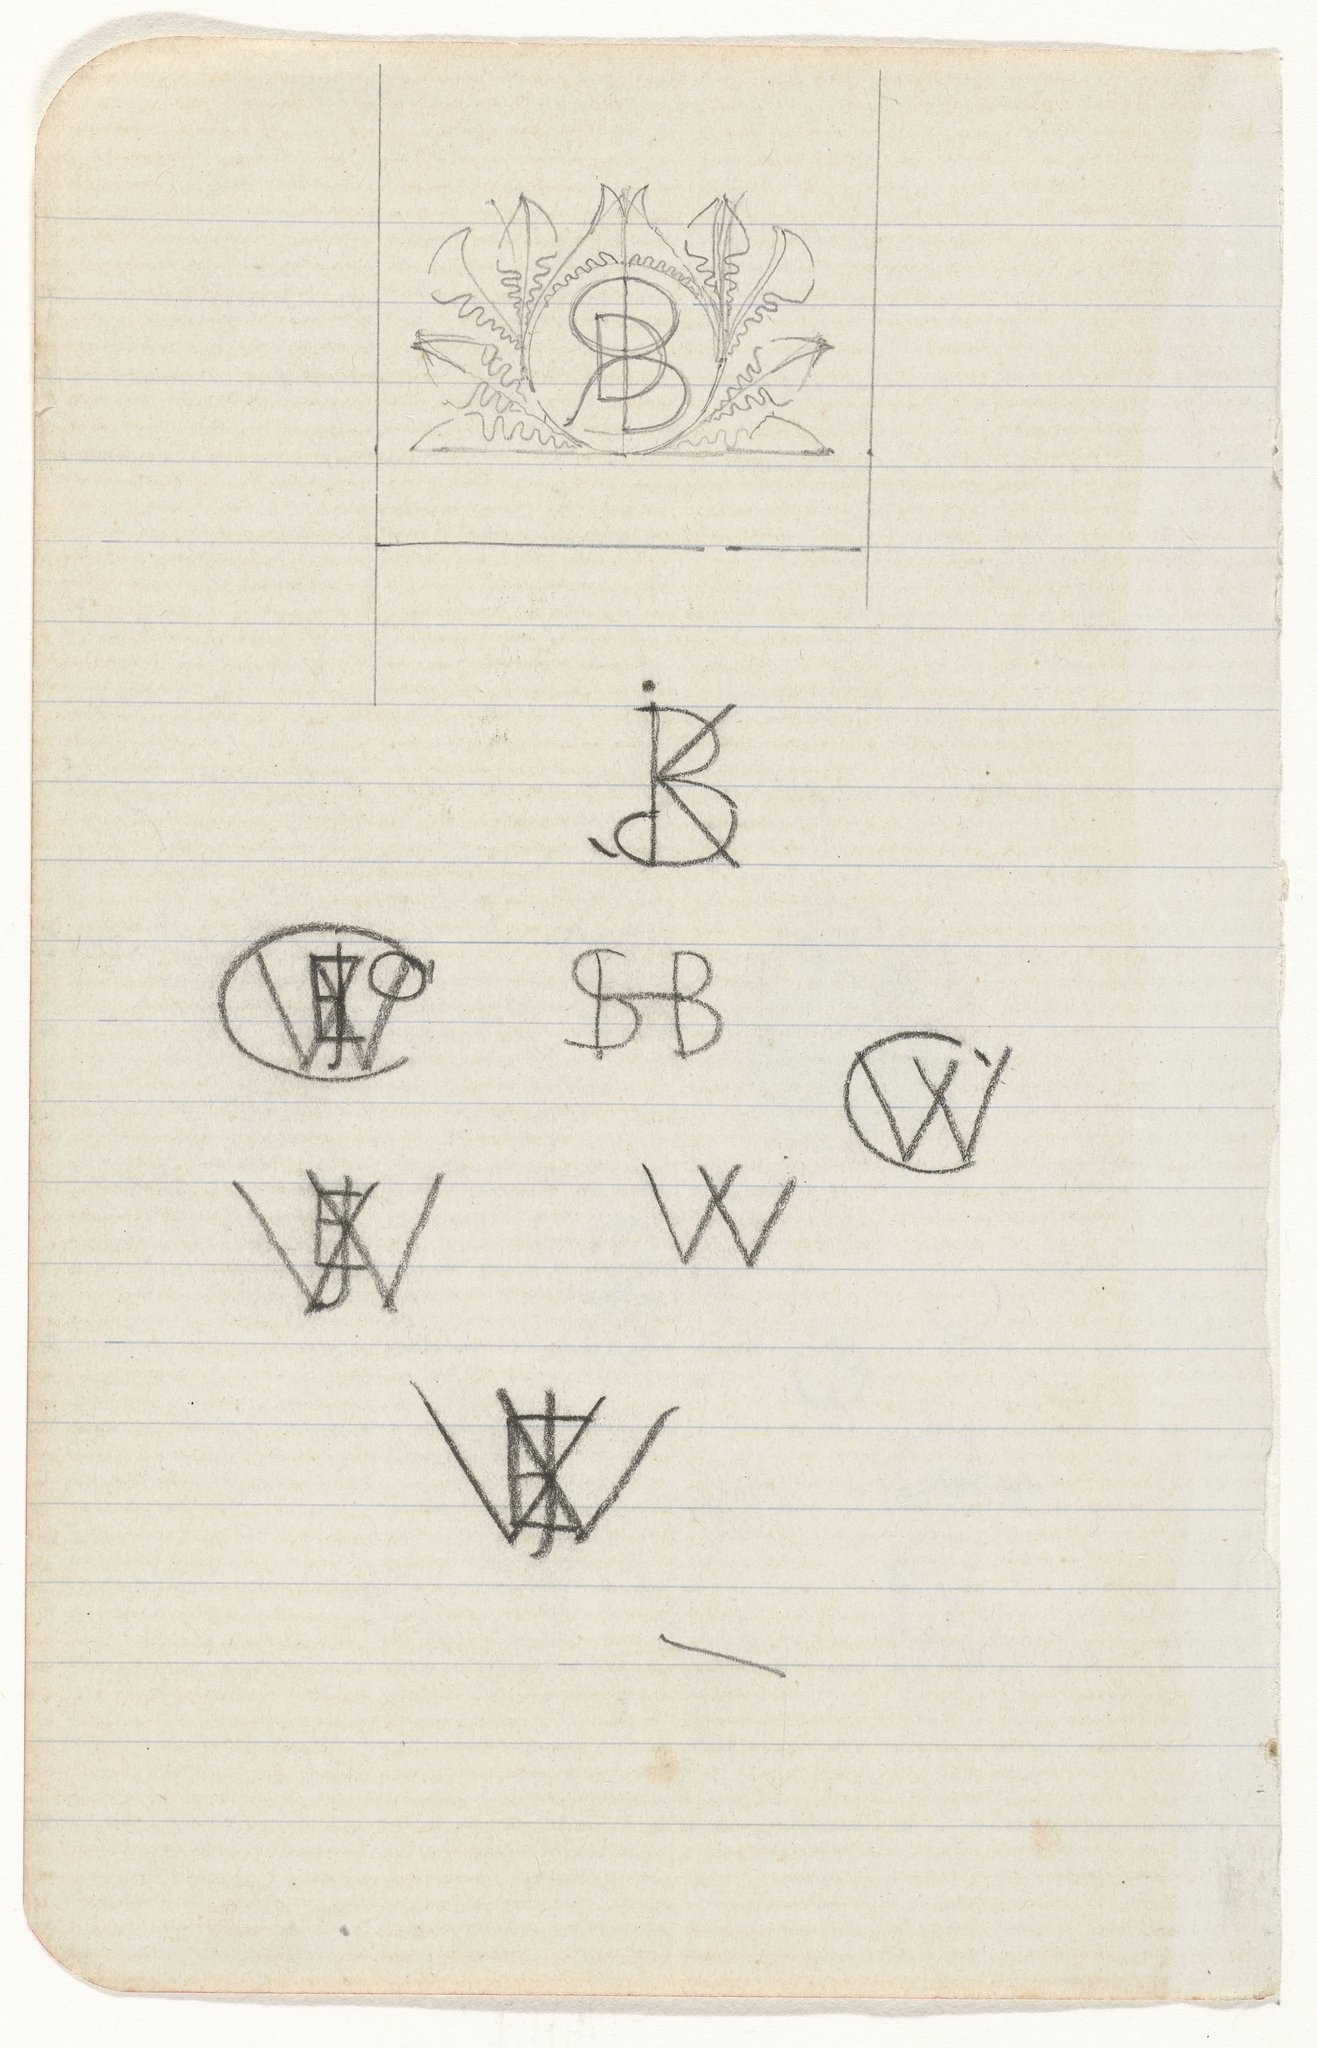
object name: design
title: Ontwerpen voor een ex libris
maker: gerrit willem dijsselhof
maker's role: designer, draughtsman, print maker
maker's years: 1866-1924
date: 1876-1924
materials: chalk, paper, pencil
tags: ex-libris